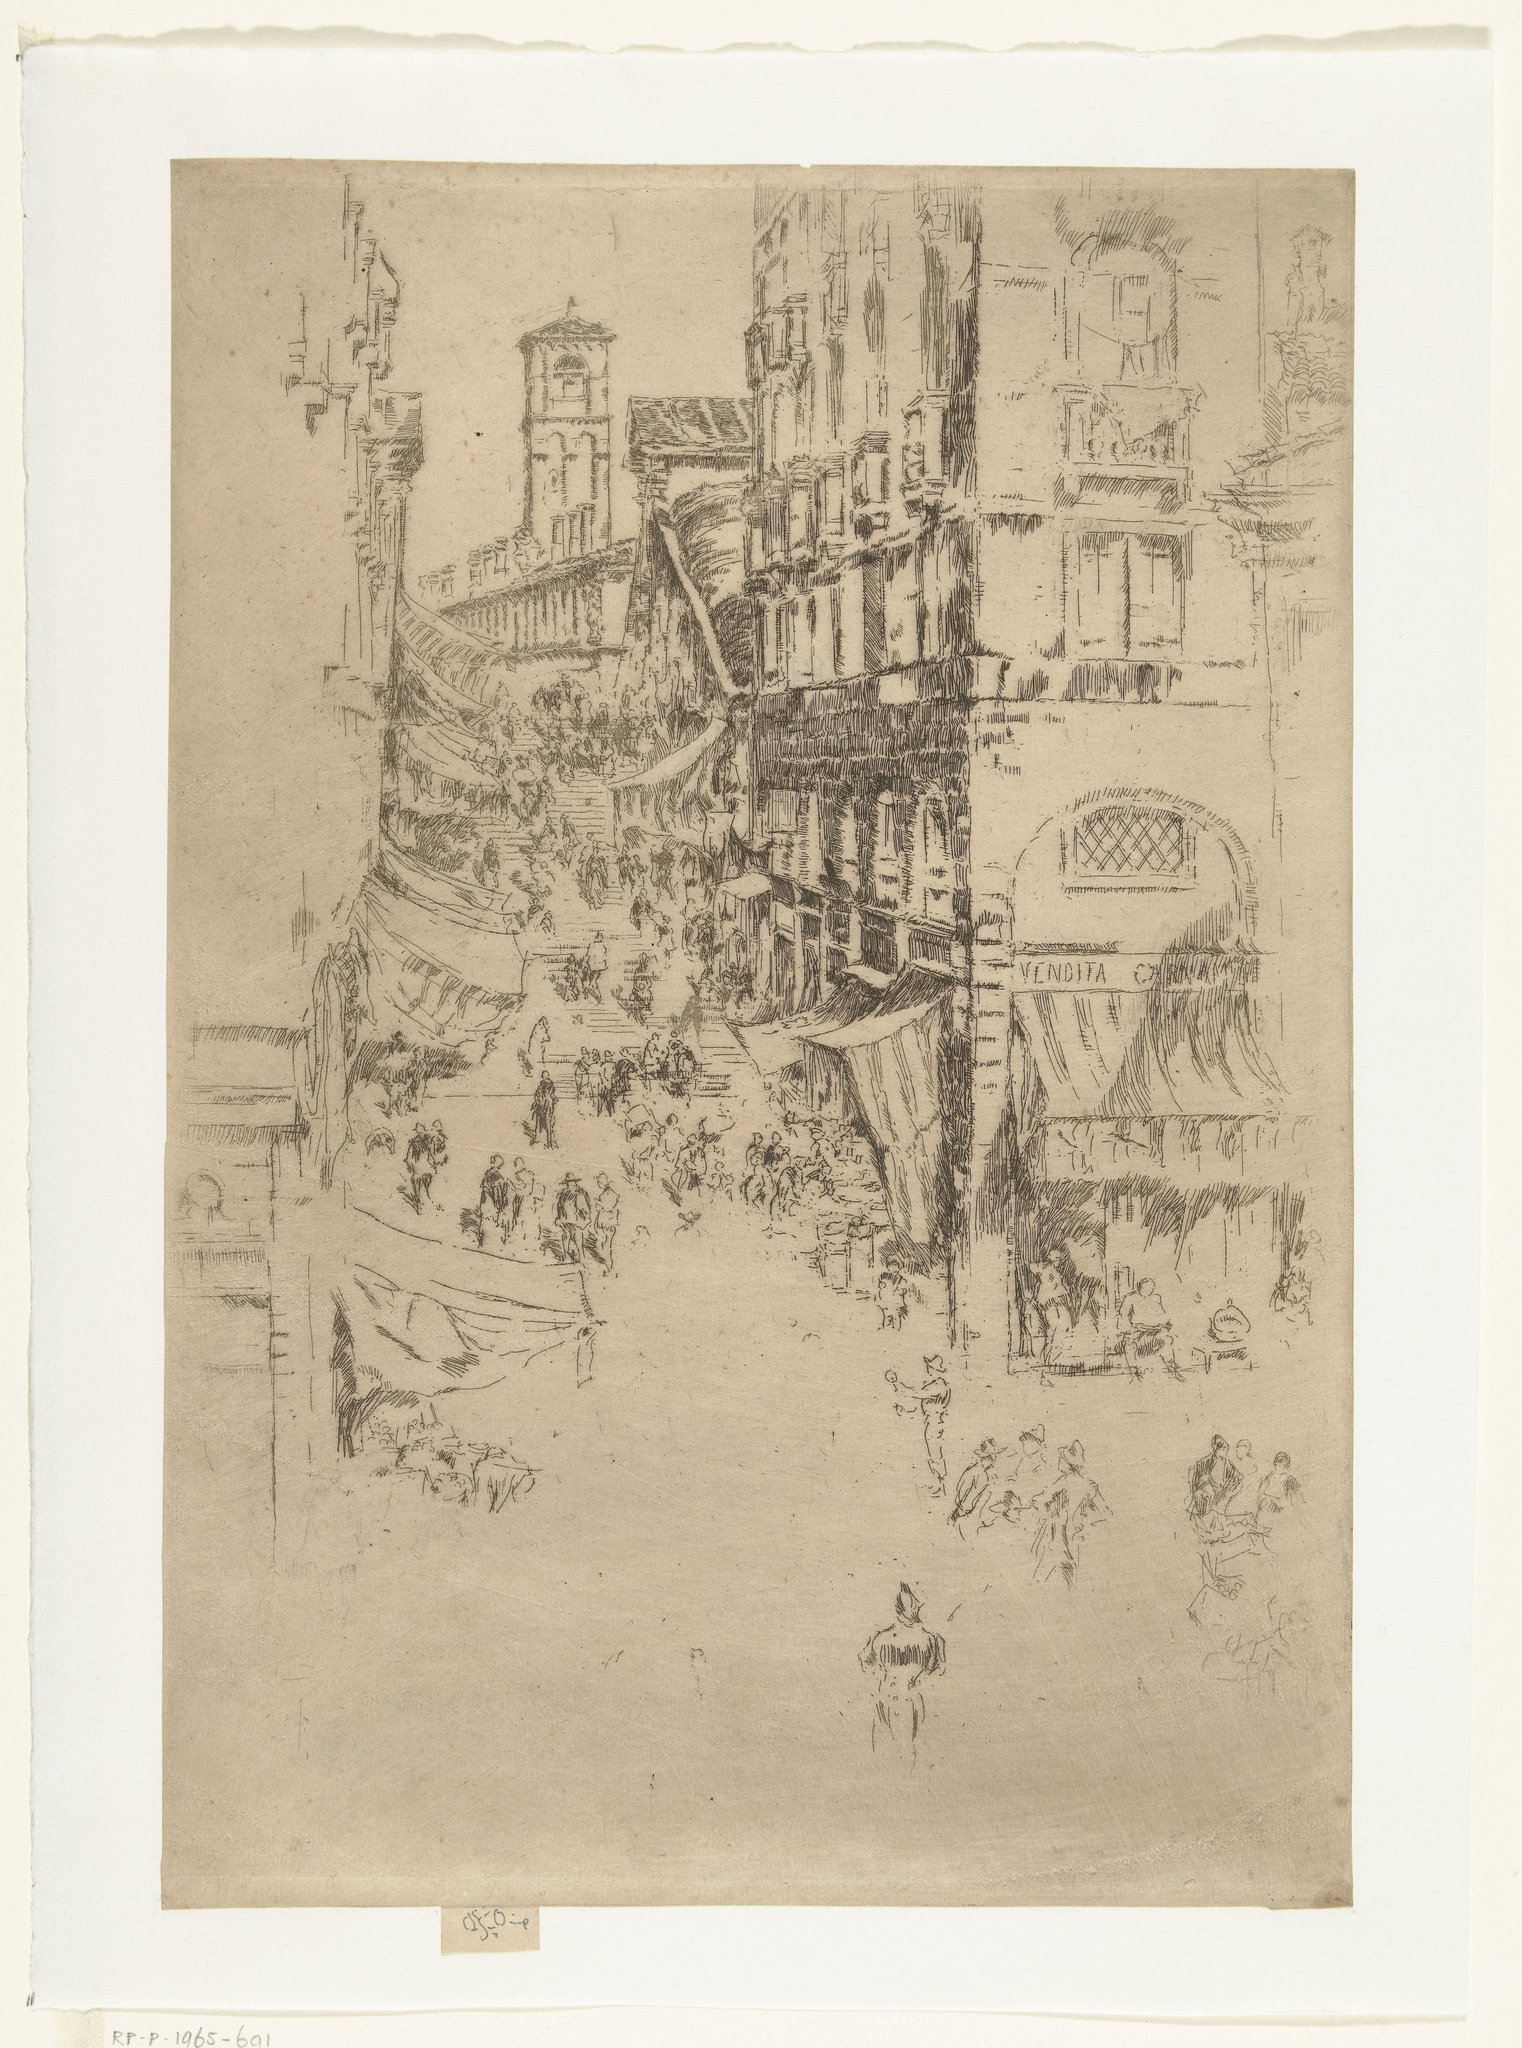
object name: print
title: A set of twenty-six etchings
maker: james abbott mcneill whistler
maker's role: painter, print maker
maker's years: 1834-1903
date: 1879-1880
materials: paper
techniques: drypoint, etching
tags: bridge in city with structures, i.e. shops, houses, e.g. ponte vecchio in florence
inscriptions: collector's mark: Lugt 2760, signature: ‘JW imp’, collector's mark: Lugt 2228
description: Gezicht op de druk bewandelde opgang van de Rialtobrug, met daarachter de toren van de San Giovanni Elemosinario zichtbaar.